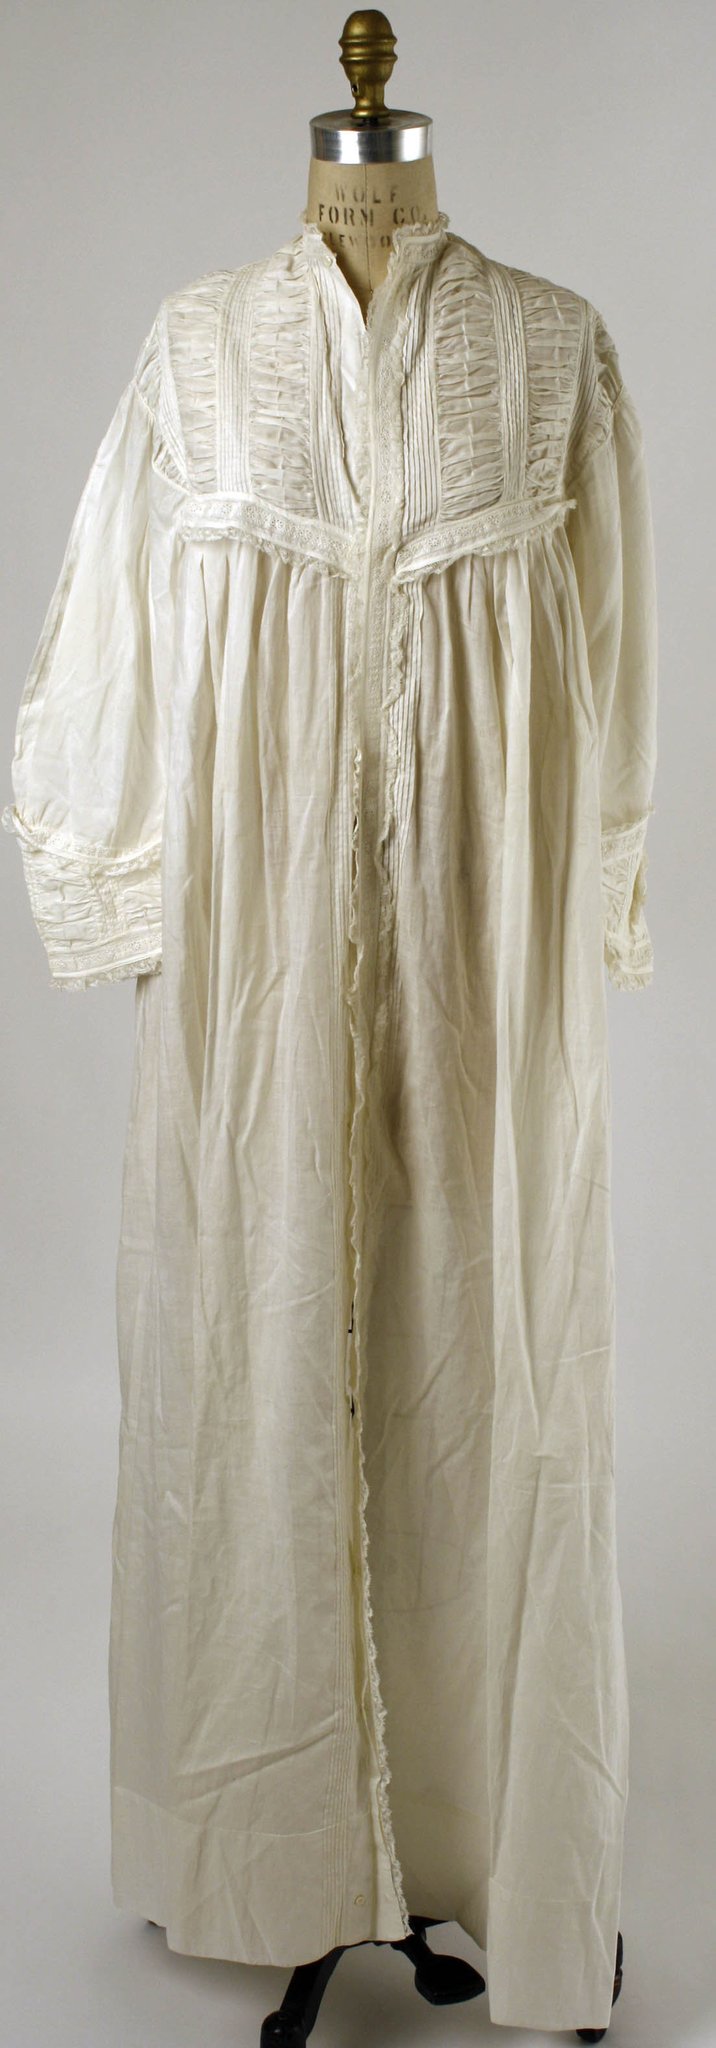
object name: nightgown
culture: american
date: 1890-1899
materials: cotton